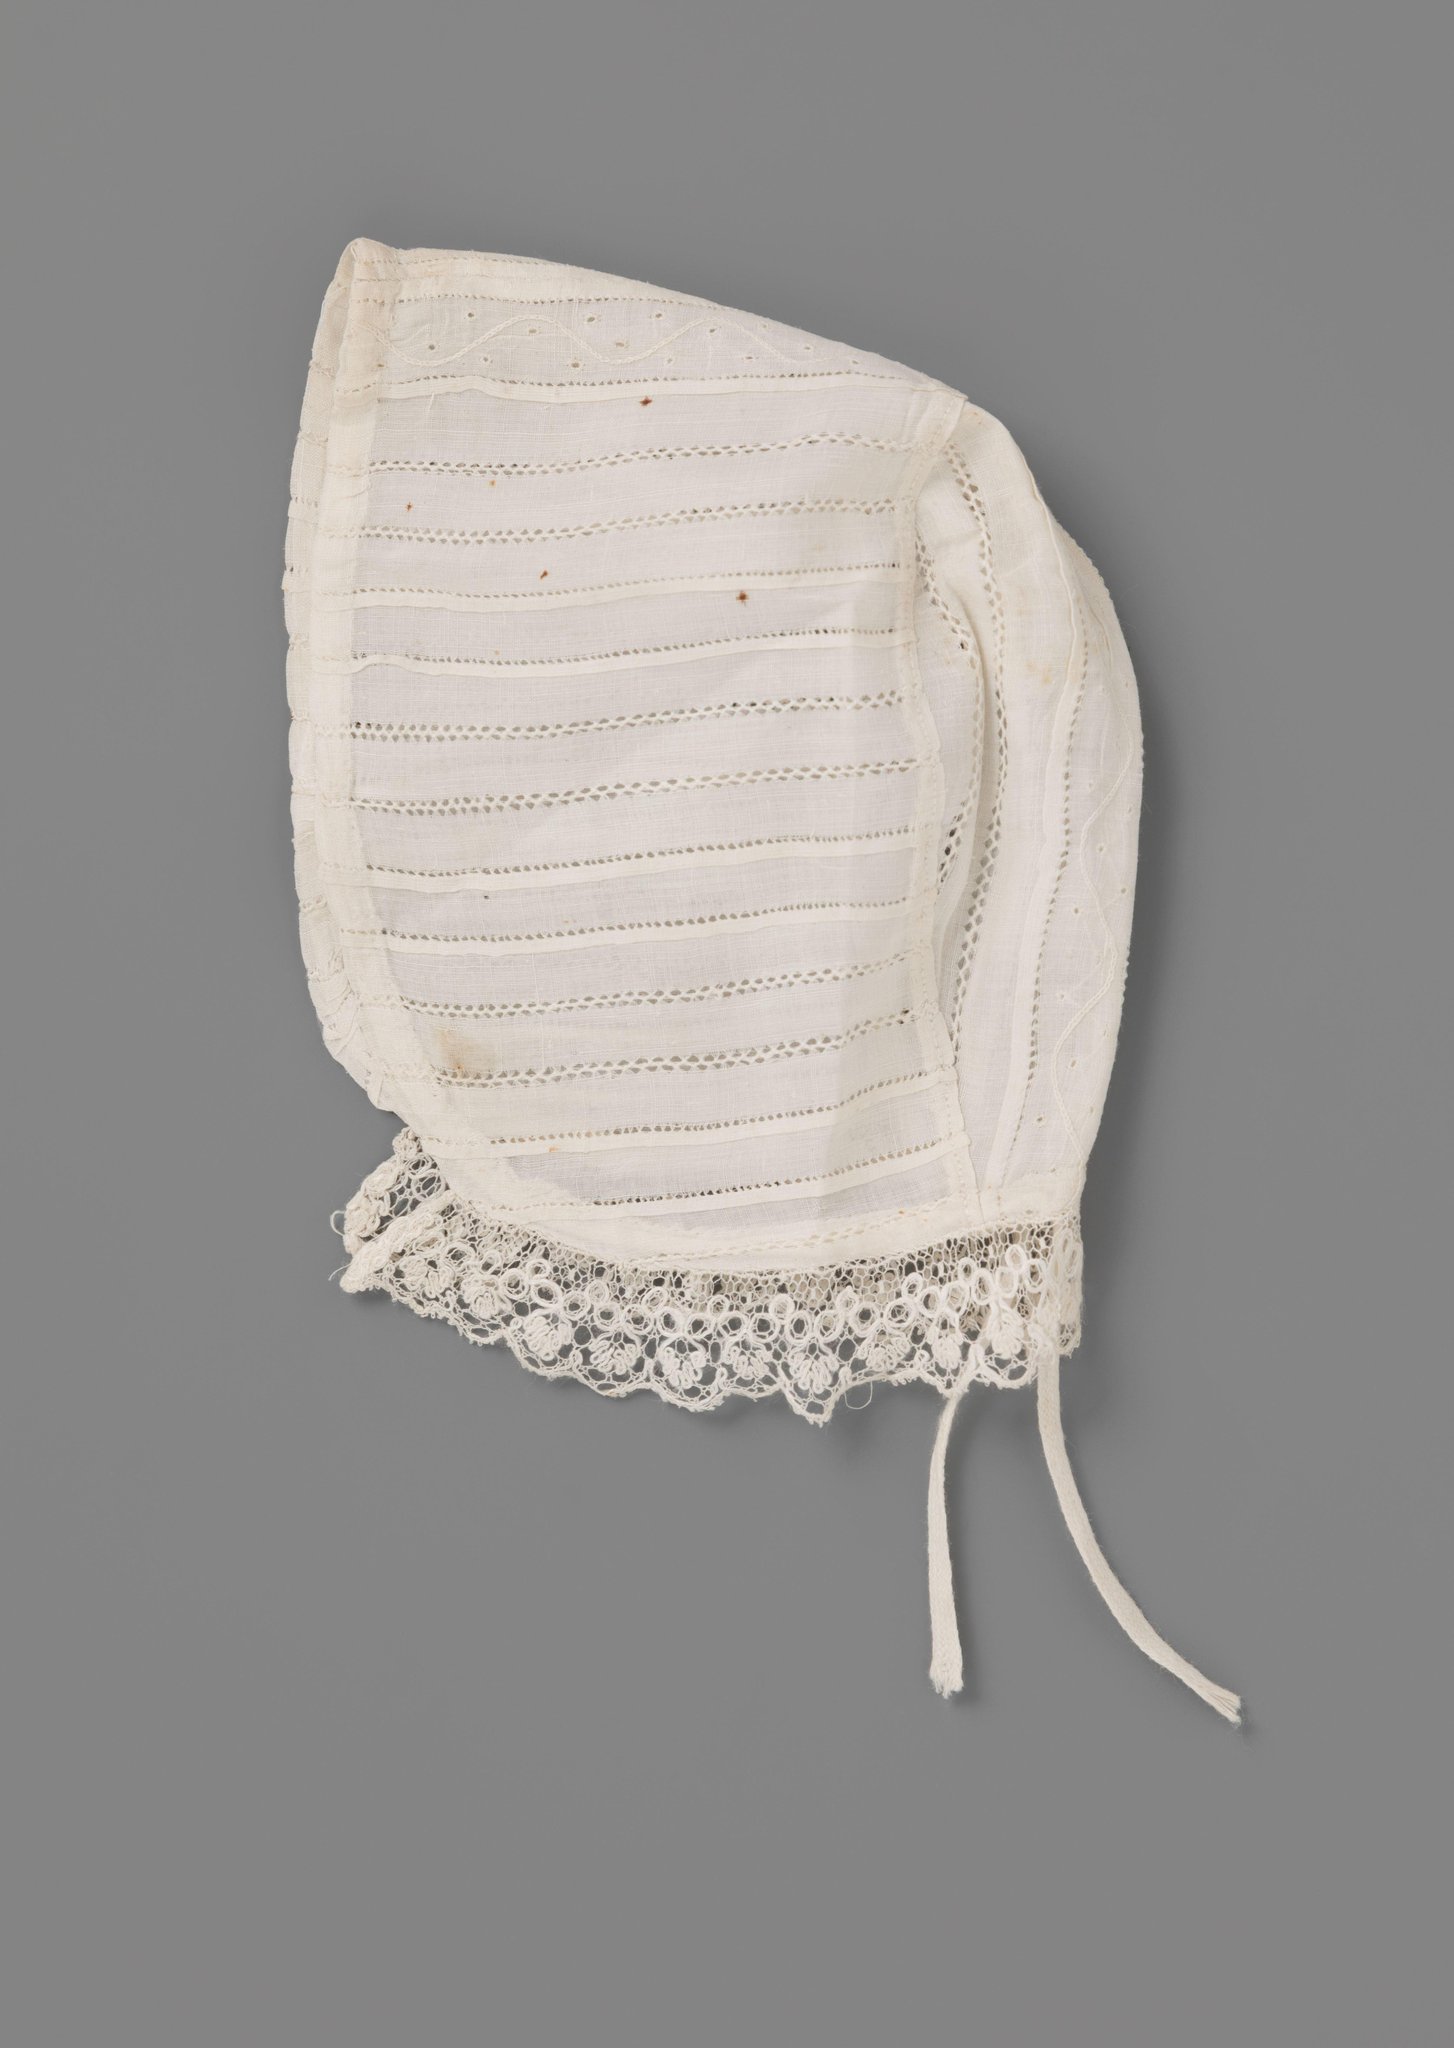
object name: cap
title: Babymuts van linnenbatist met oprijgsels en ajour werk, en een rand van Rijsselse kant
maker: Anonymous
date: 1850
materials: linen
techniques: lace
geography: western europe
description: Babymuts van linnenbatist. De muts is versierd met banen fils tirés en opgenaaide stroken. De muts is afgezet met een rand Rijsselse kant.